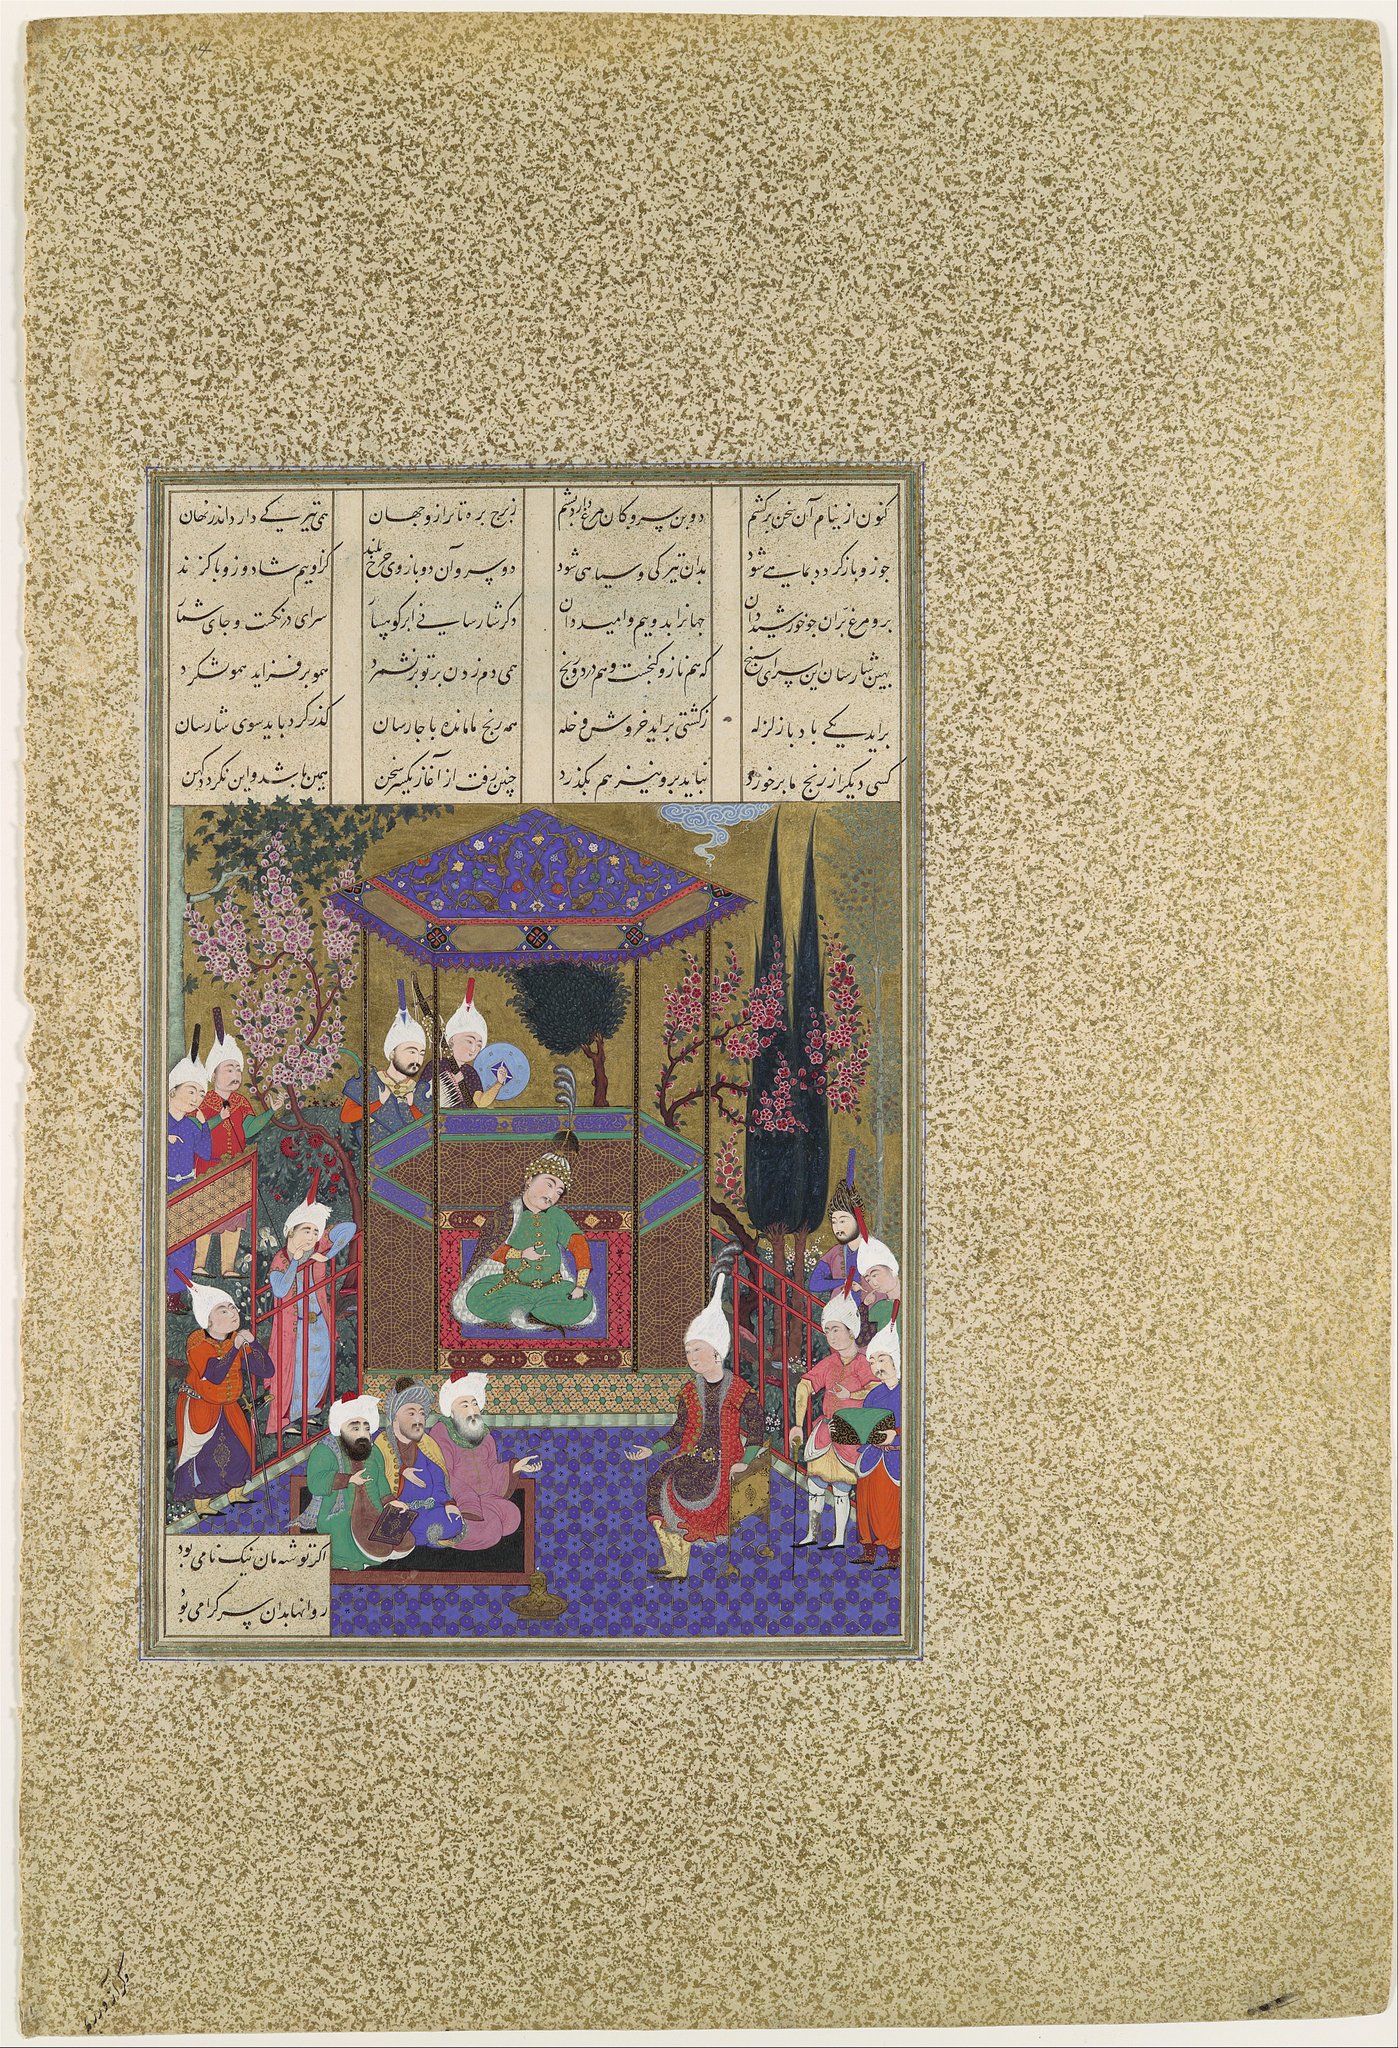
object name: folio from an illustrated manuscript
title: "Zal Expounds the Mysteries of the Magi", Folio 87v from the Shahnama (Book of Kings) of Shah Tahmasp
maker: abu'l qasim firdausi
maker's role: author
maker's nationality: iranian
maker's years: 935-1020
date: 1525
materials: gold, ink, paper, silver, watercolor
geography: iran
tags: poetry,men